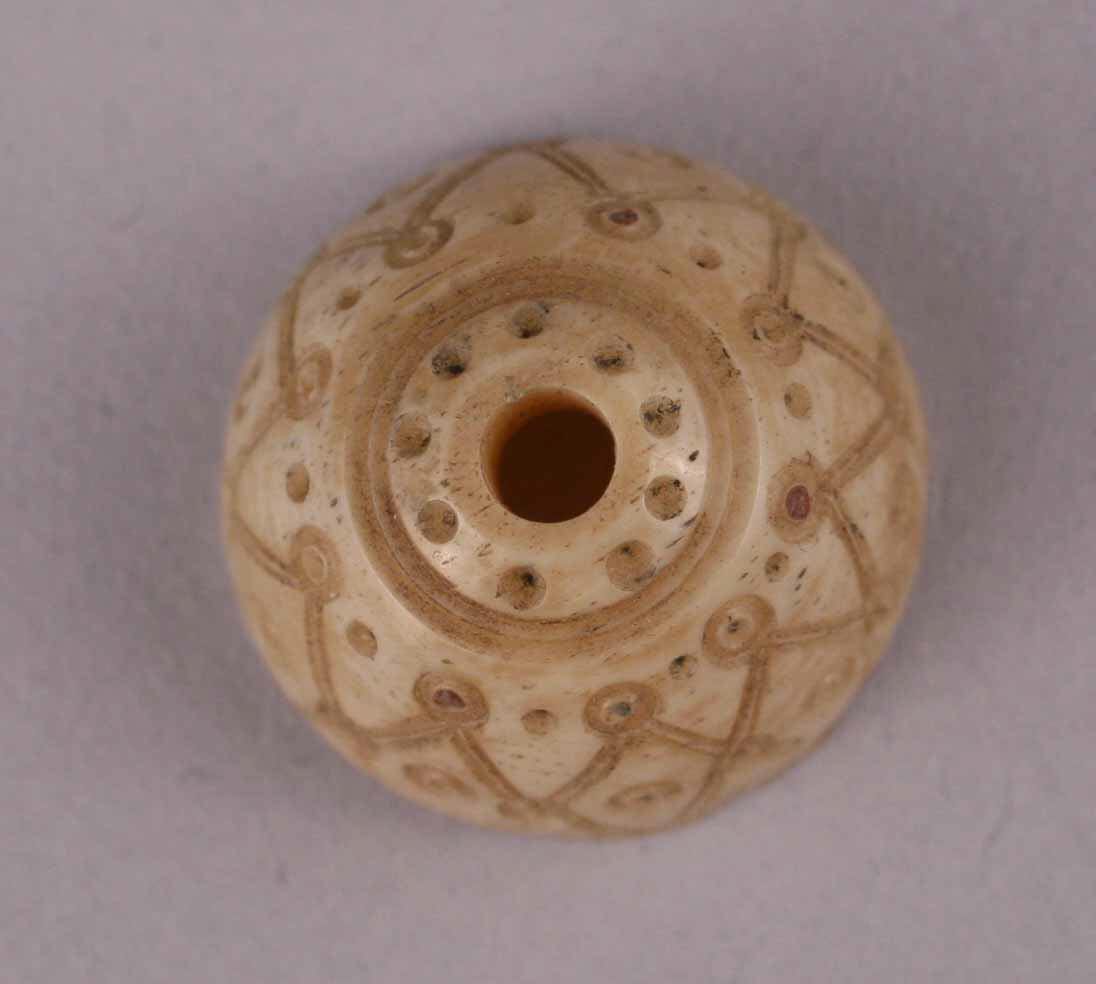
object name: button or bead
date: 801-1000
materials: bone, paint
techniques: incising, inlay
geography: iran